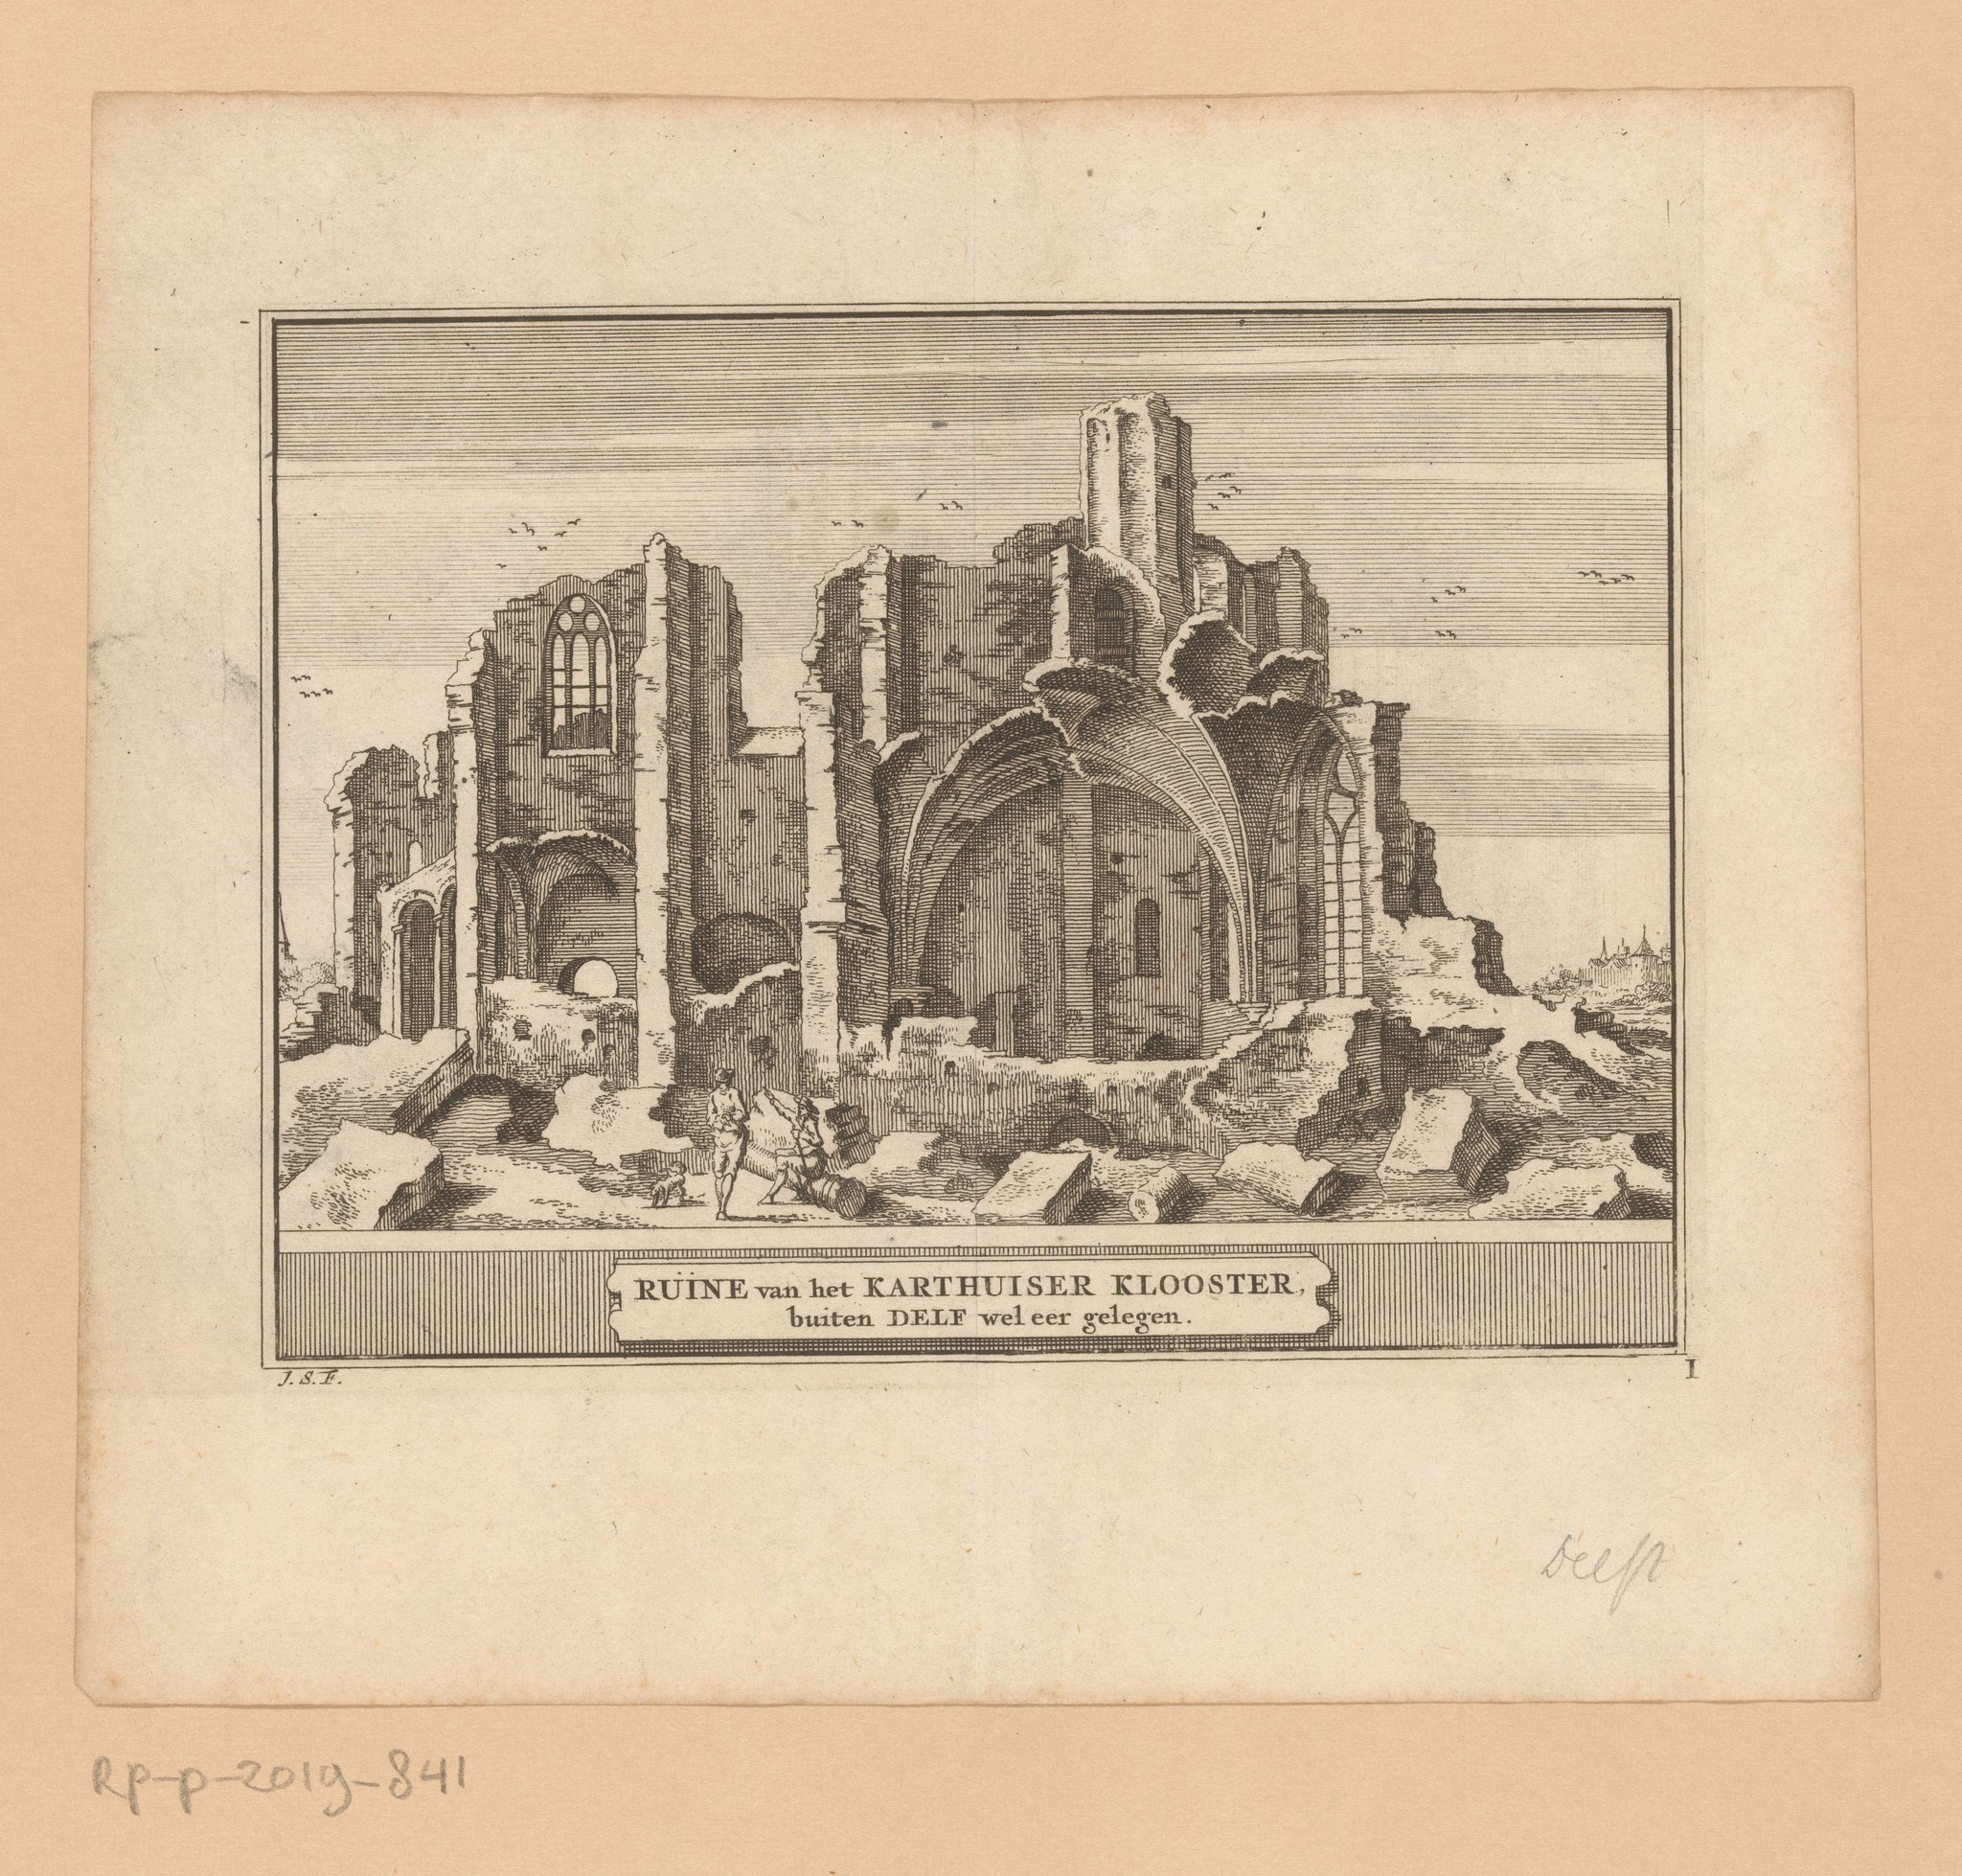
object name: book illustration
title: Ruïne van het Karthuiser klooster, buiten Delf wel eer gelegen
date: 1711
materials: paper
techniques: engraving, etching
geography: amsterdam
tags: ruin of church, monastery, etc., landscape with ruins (+ city(-scape) with figures, staffage)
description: Prent voor het eerst gebruikt in: Smids, Ludolph. Schatkamer der Nederlandsse oudheden; of Woordenboek, behelsende Nederlands steden. Amsterdam: Pieter de Coup, 1711, tussen. p. 180 en 181. Verscheen daarna mogelijk in heruitgaven van dit werk in 1737 en 1774. In 1721 verscheen er een uitgave met alleen de prenten: Nederlandsche oudheden, bestaande in zestig verbeeldingen (...) gelegen in Holland, 't Sticht van Utrecht en Gelderland enz. Amsterdam: Hendrik Bosch, 1721.